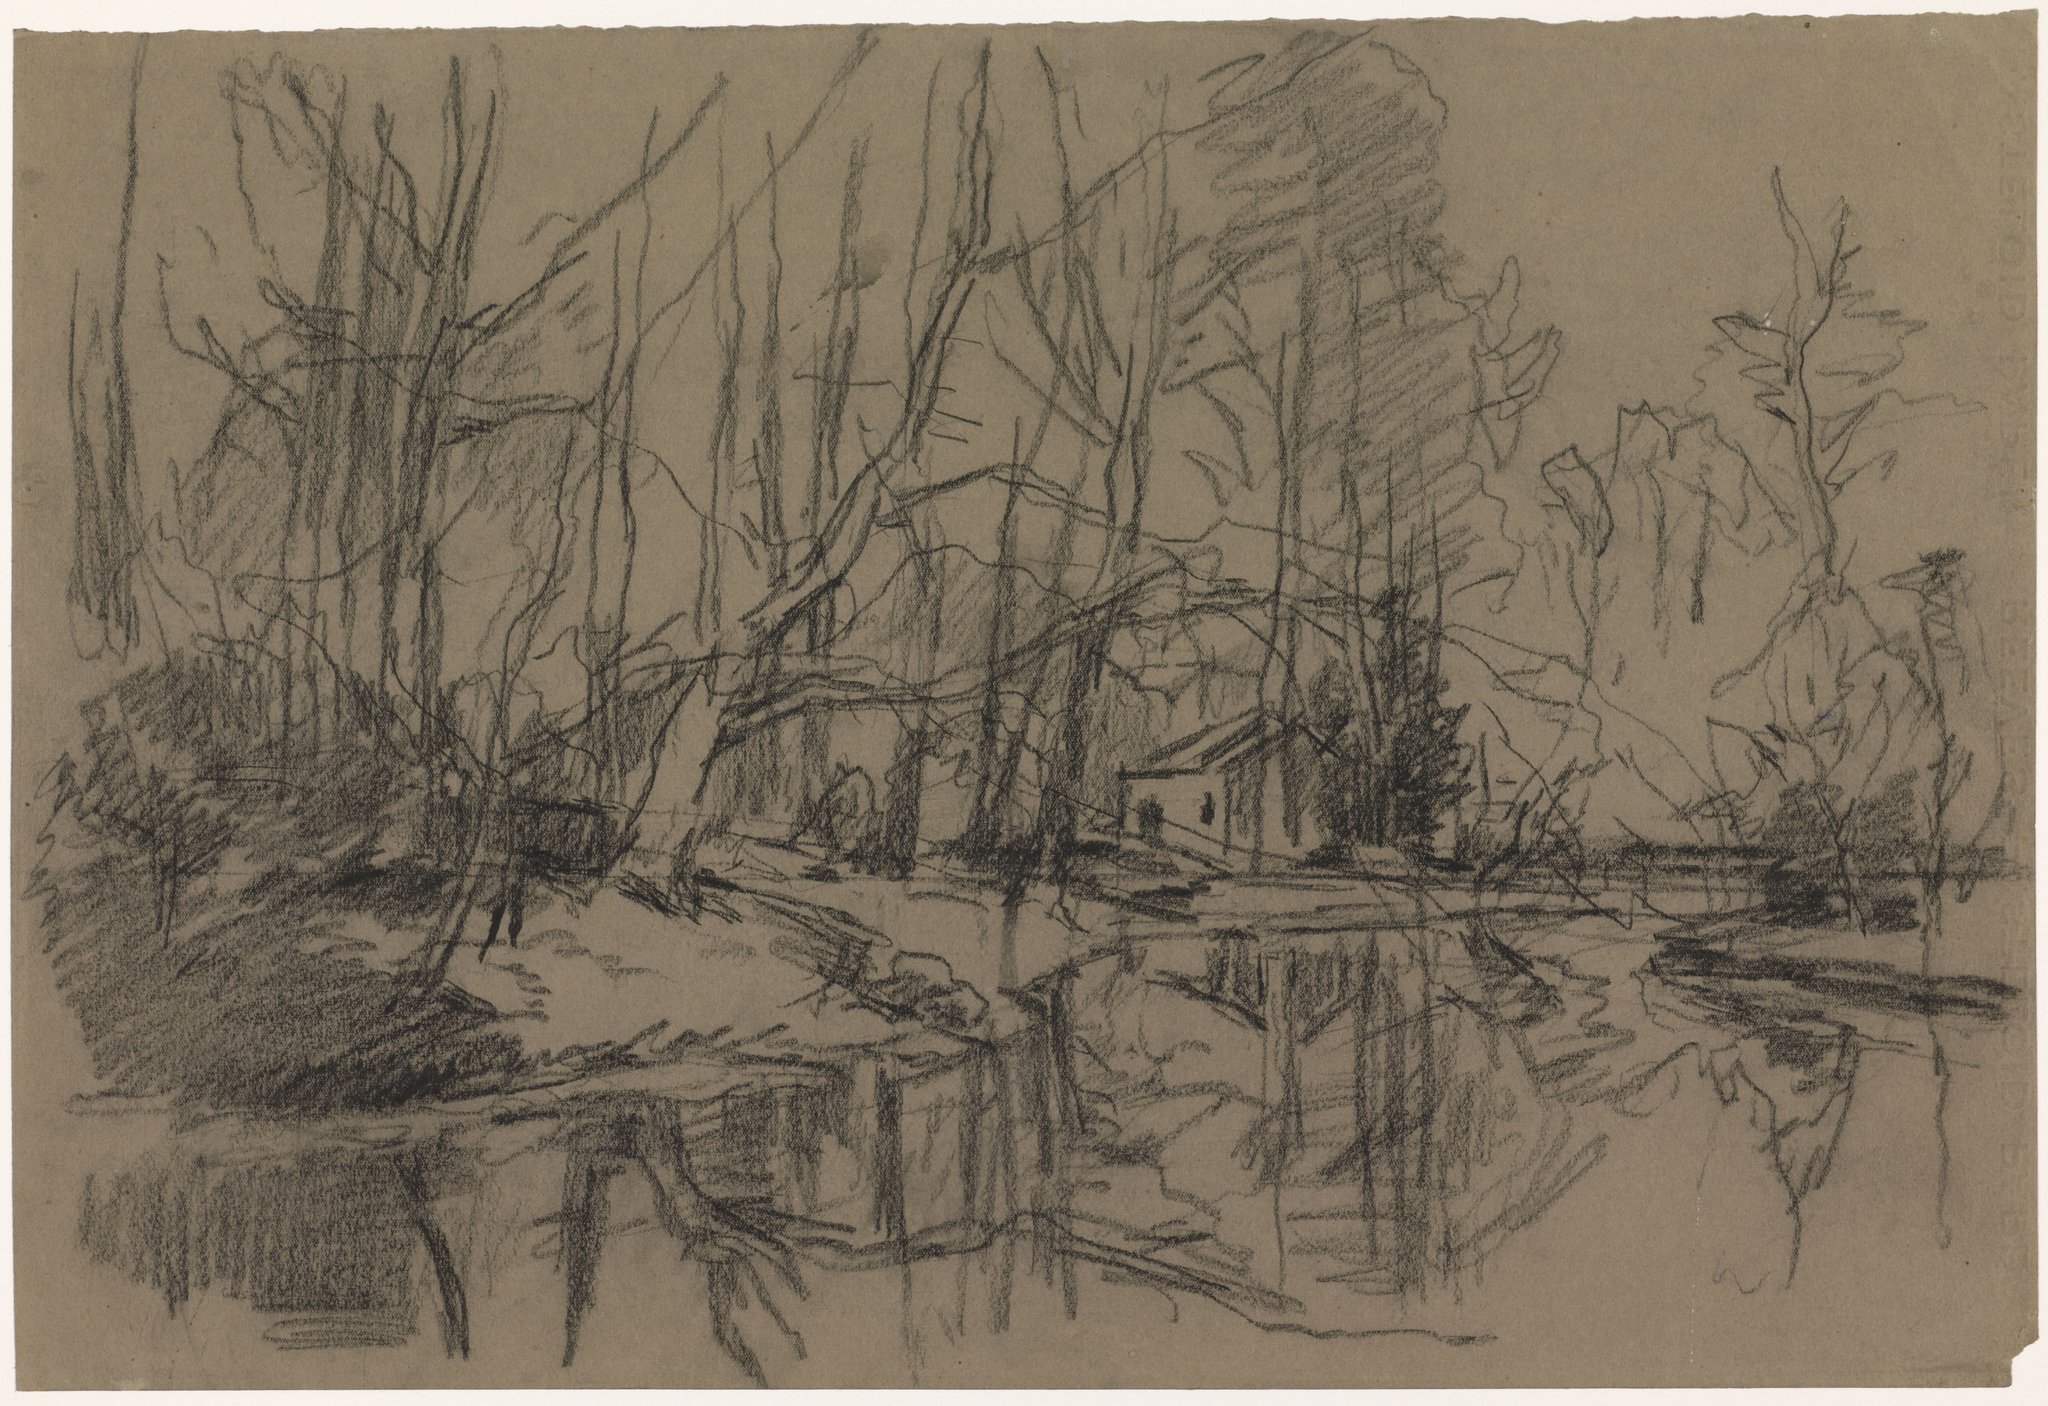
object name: drawing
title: Bosgezicht met vijver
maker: egbert rubertus derk schaap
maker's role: draughtsman, painter, print maker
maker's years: 1862-1939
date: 1872-1939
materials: chalk, paper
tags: forest, wood